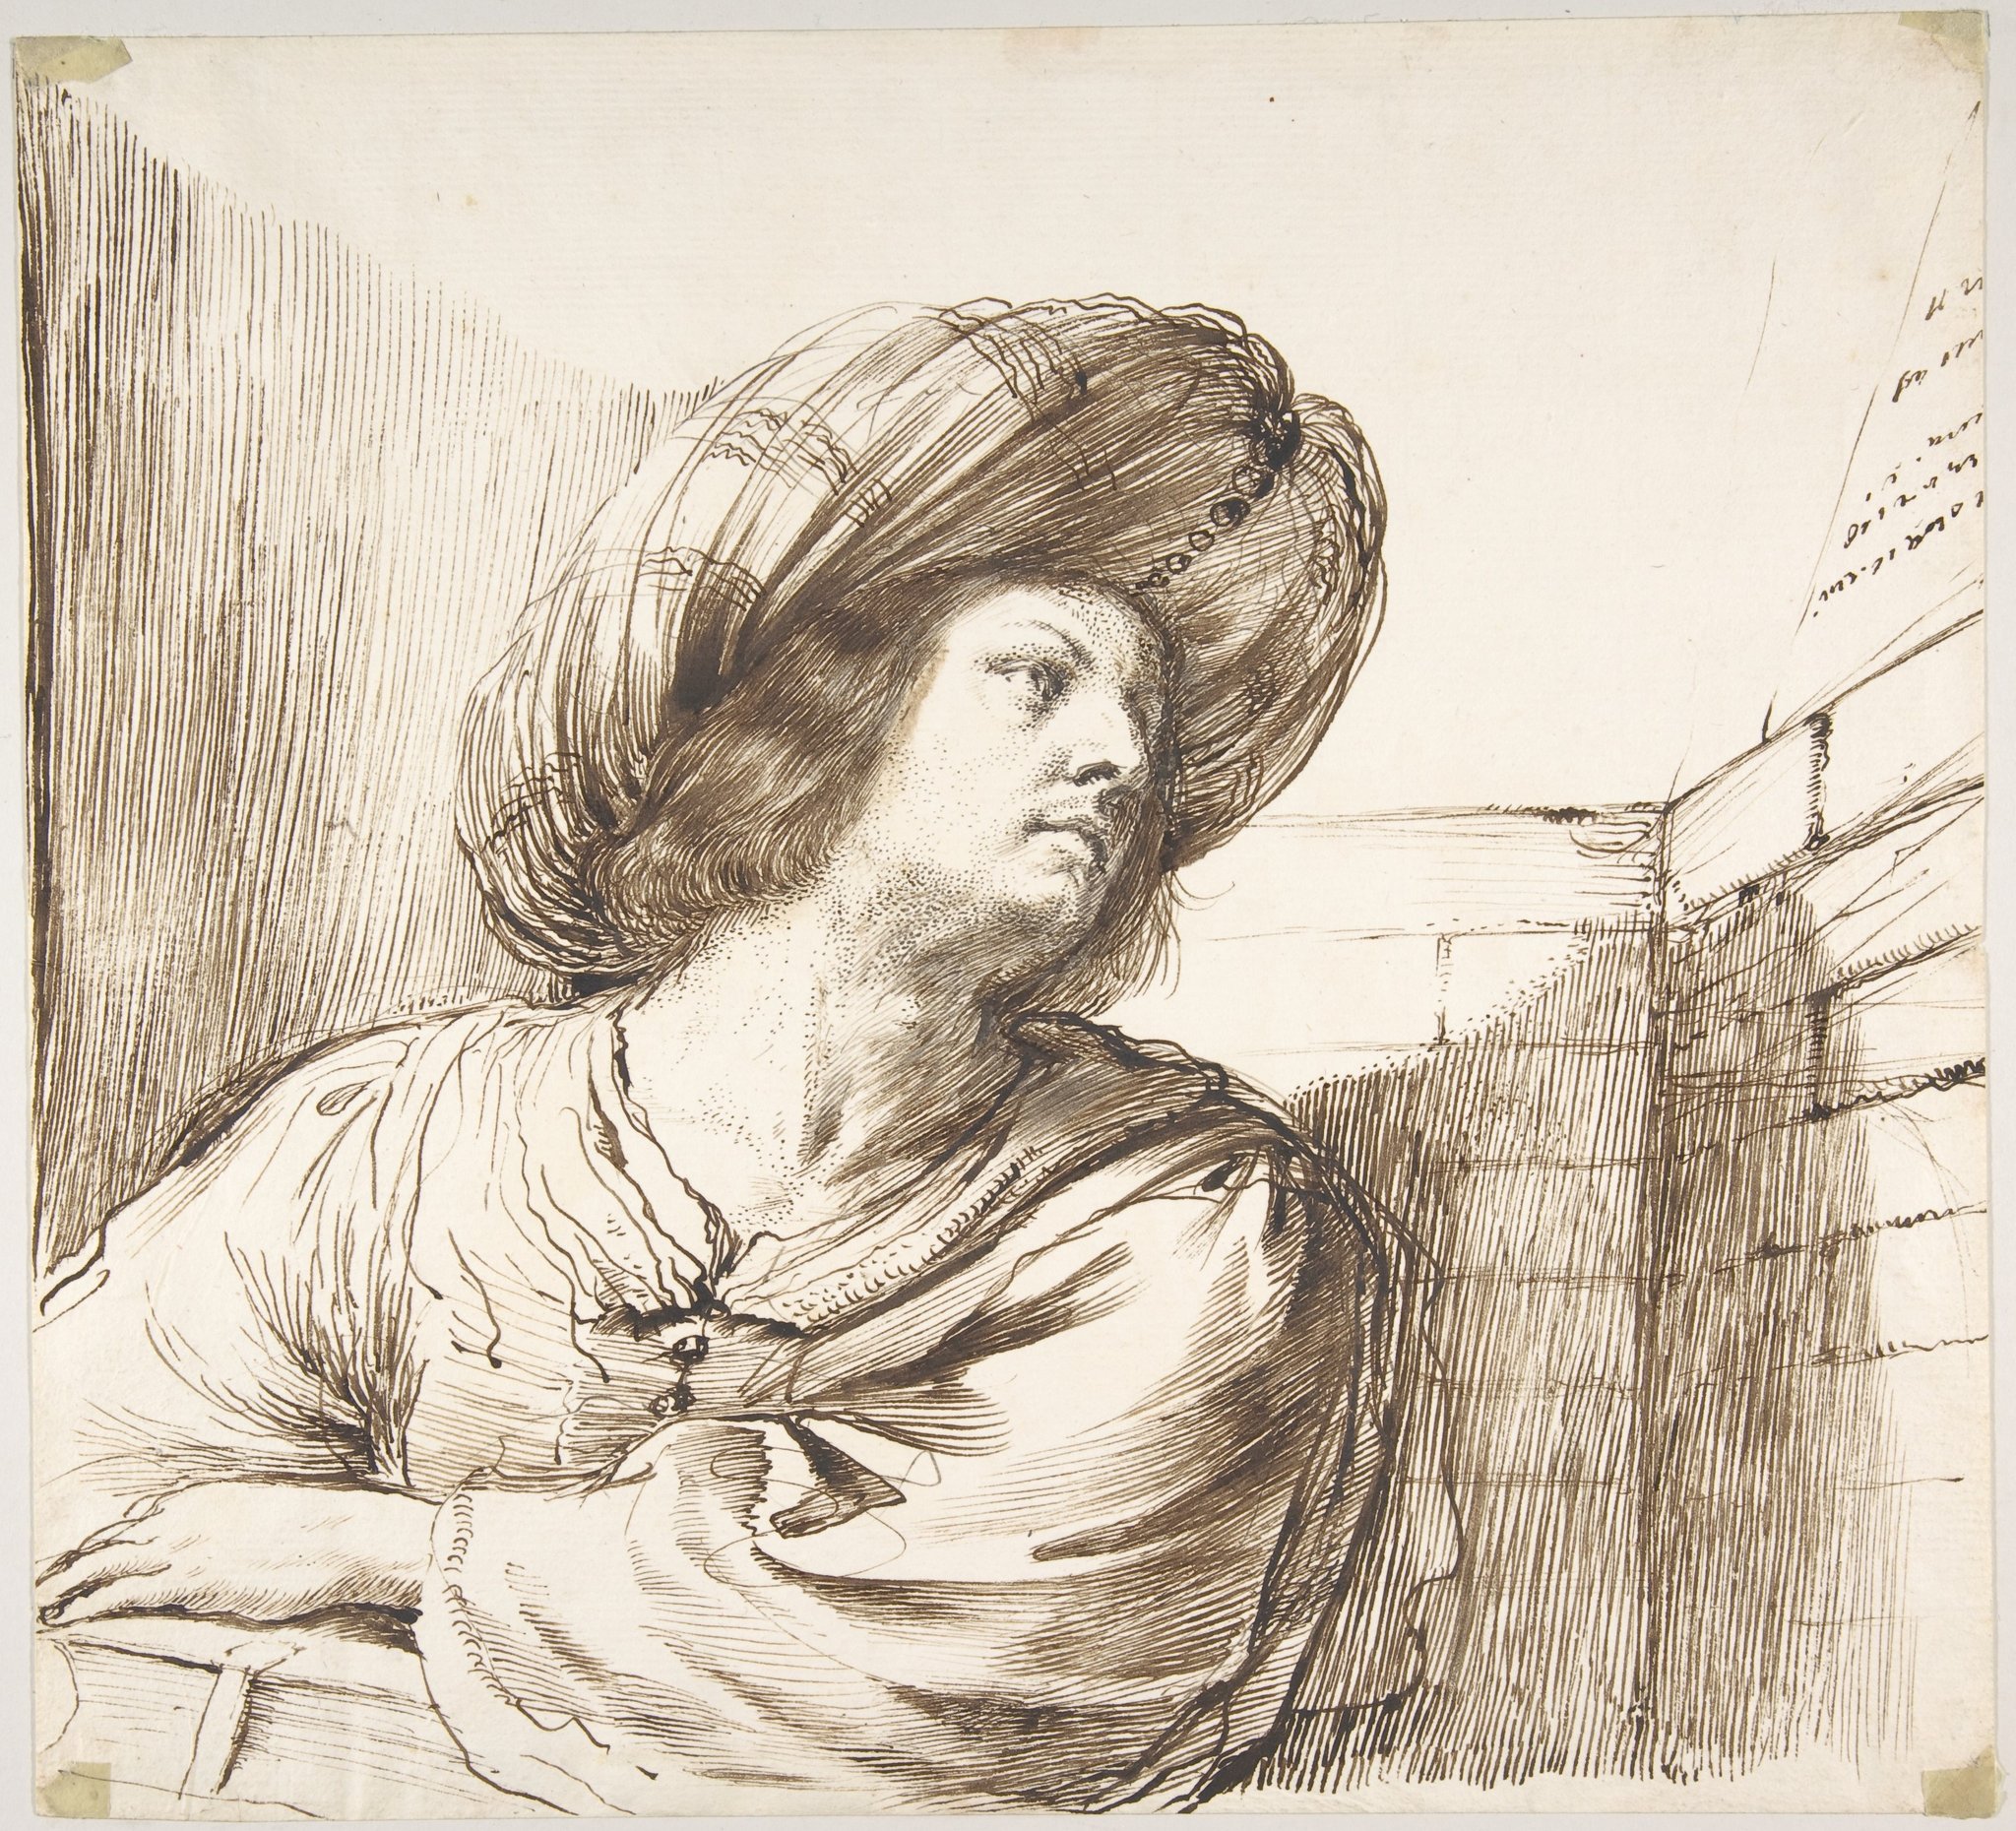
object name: drawing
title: Portrait of a Scholar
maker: guercino (giovanni francesco barbieri)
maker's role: artist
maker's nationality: italian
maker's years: 1591-1666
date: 1591-1666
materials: ink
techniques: pen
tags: portraits